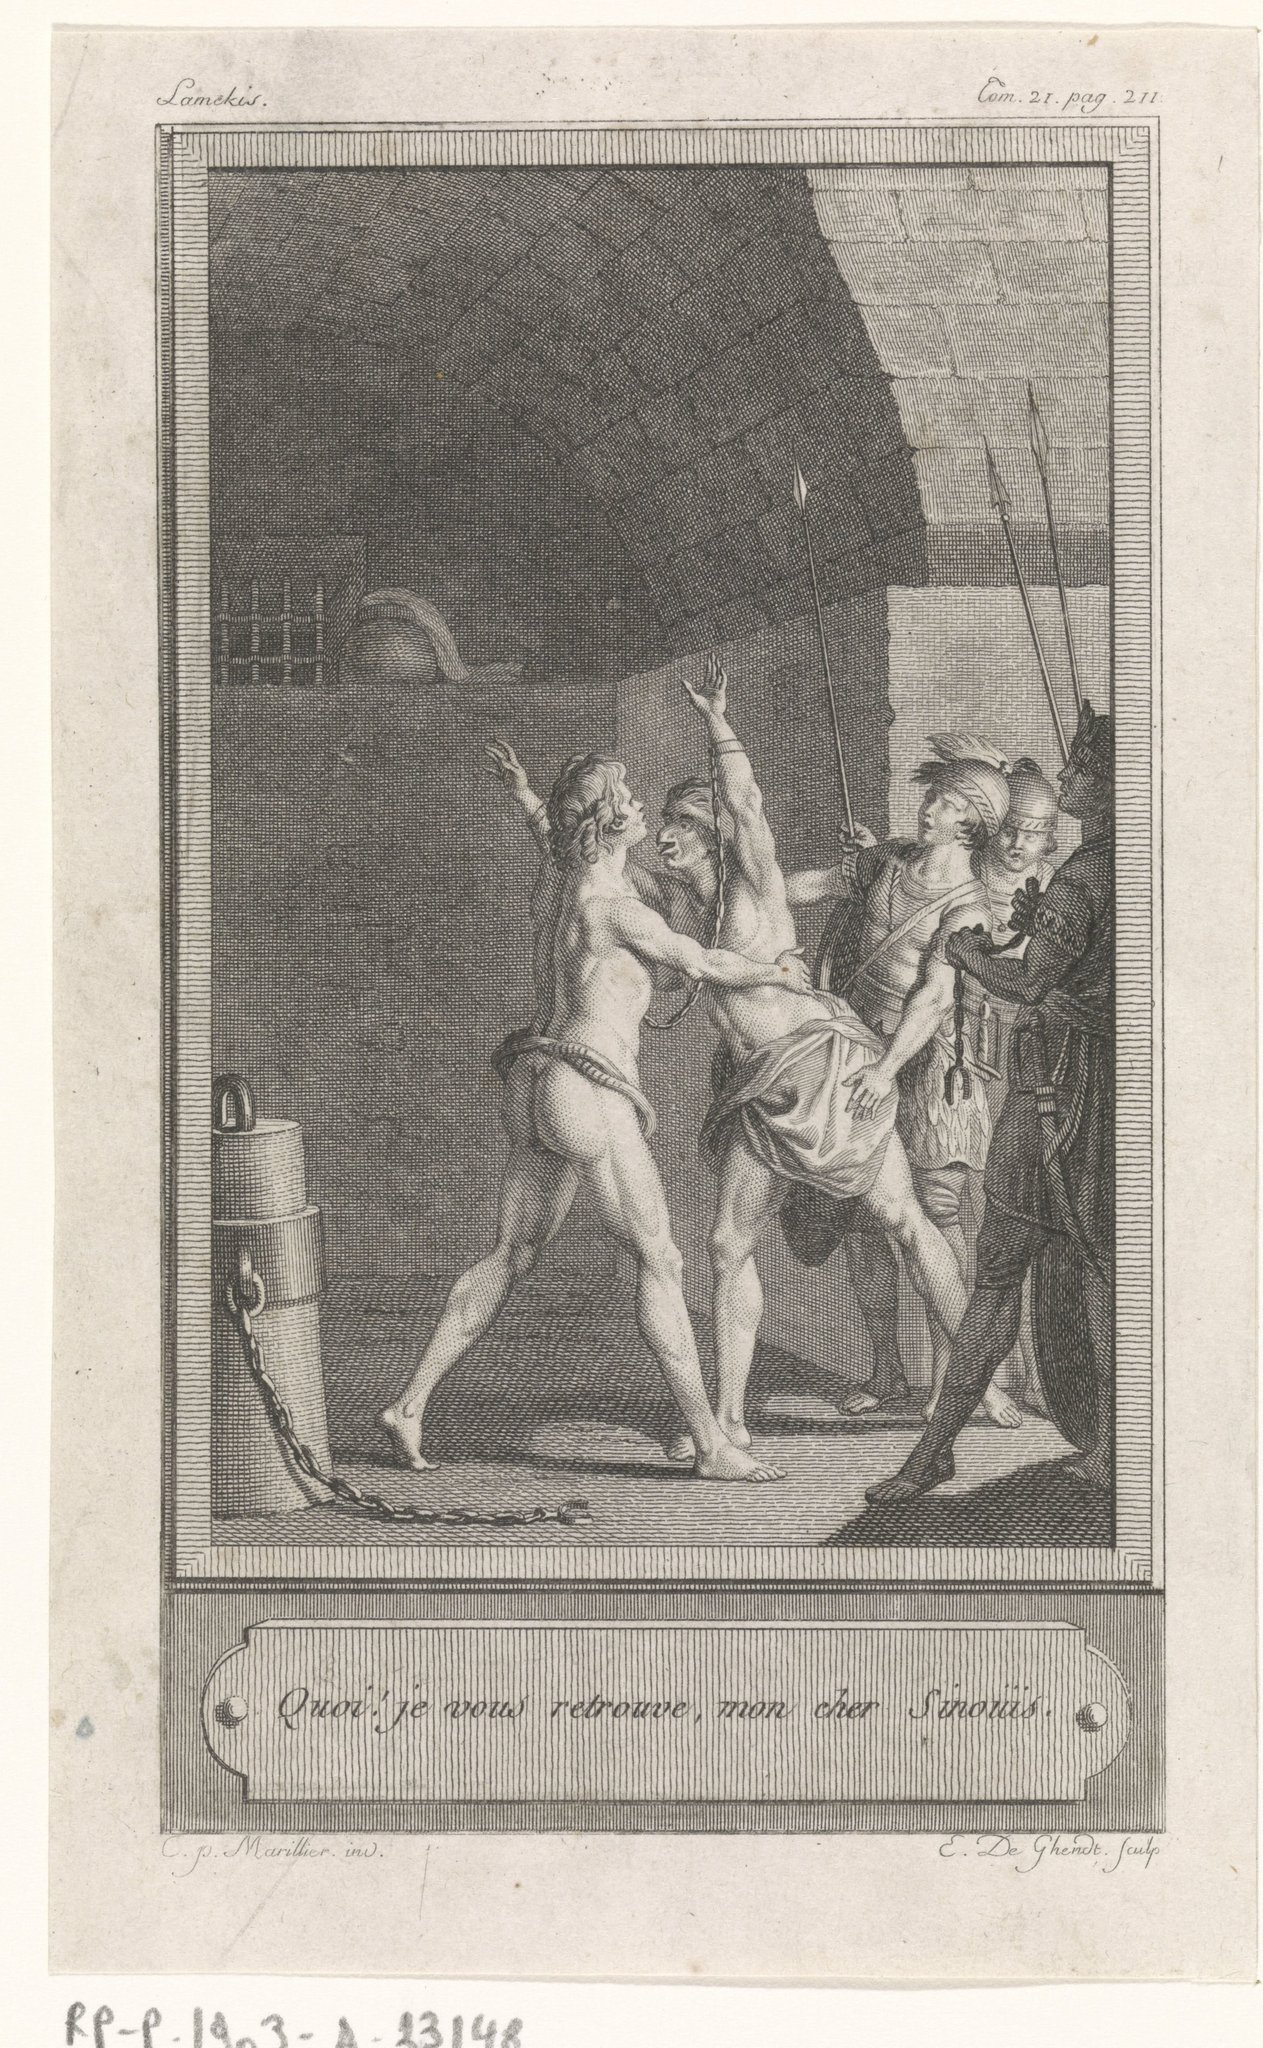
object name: book illustration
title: Lamekis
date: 1786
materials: paper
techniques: engraving, etching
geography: paris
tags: prison, jail, tales and fairy tales (with title)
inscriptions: collector's mark: Lugt 2228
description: Een voorstelling uit het verhaal van Lamekis. In de gevangenis wordt Lamekis begroet door zijn vriend Sinouïs, een man met het gezicht van een vogel. De prent heeft een Frans onderschrift.